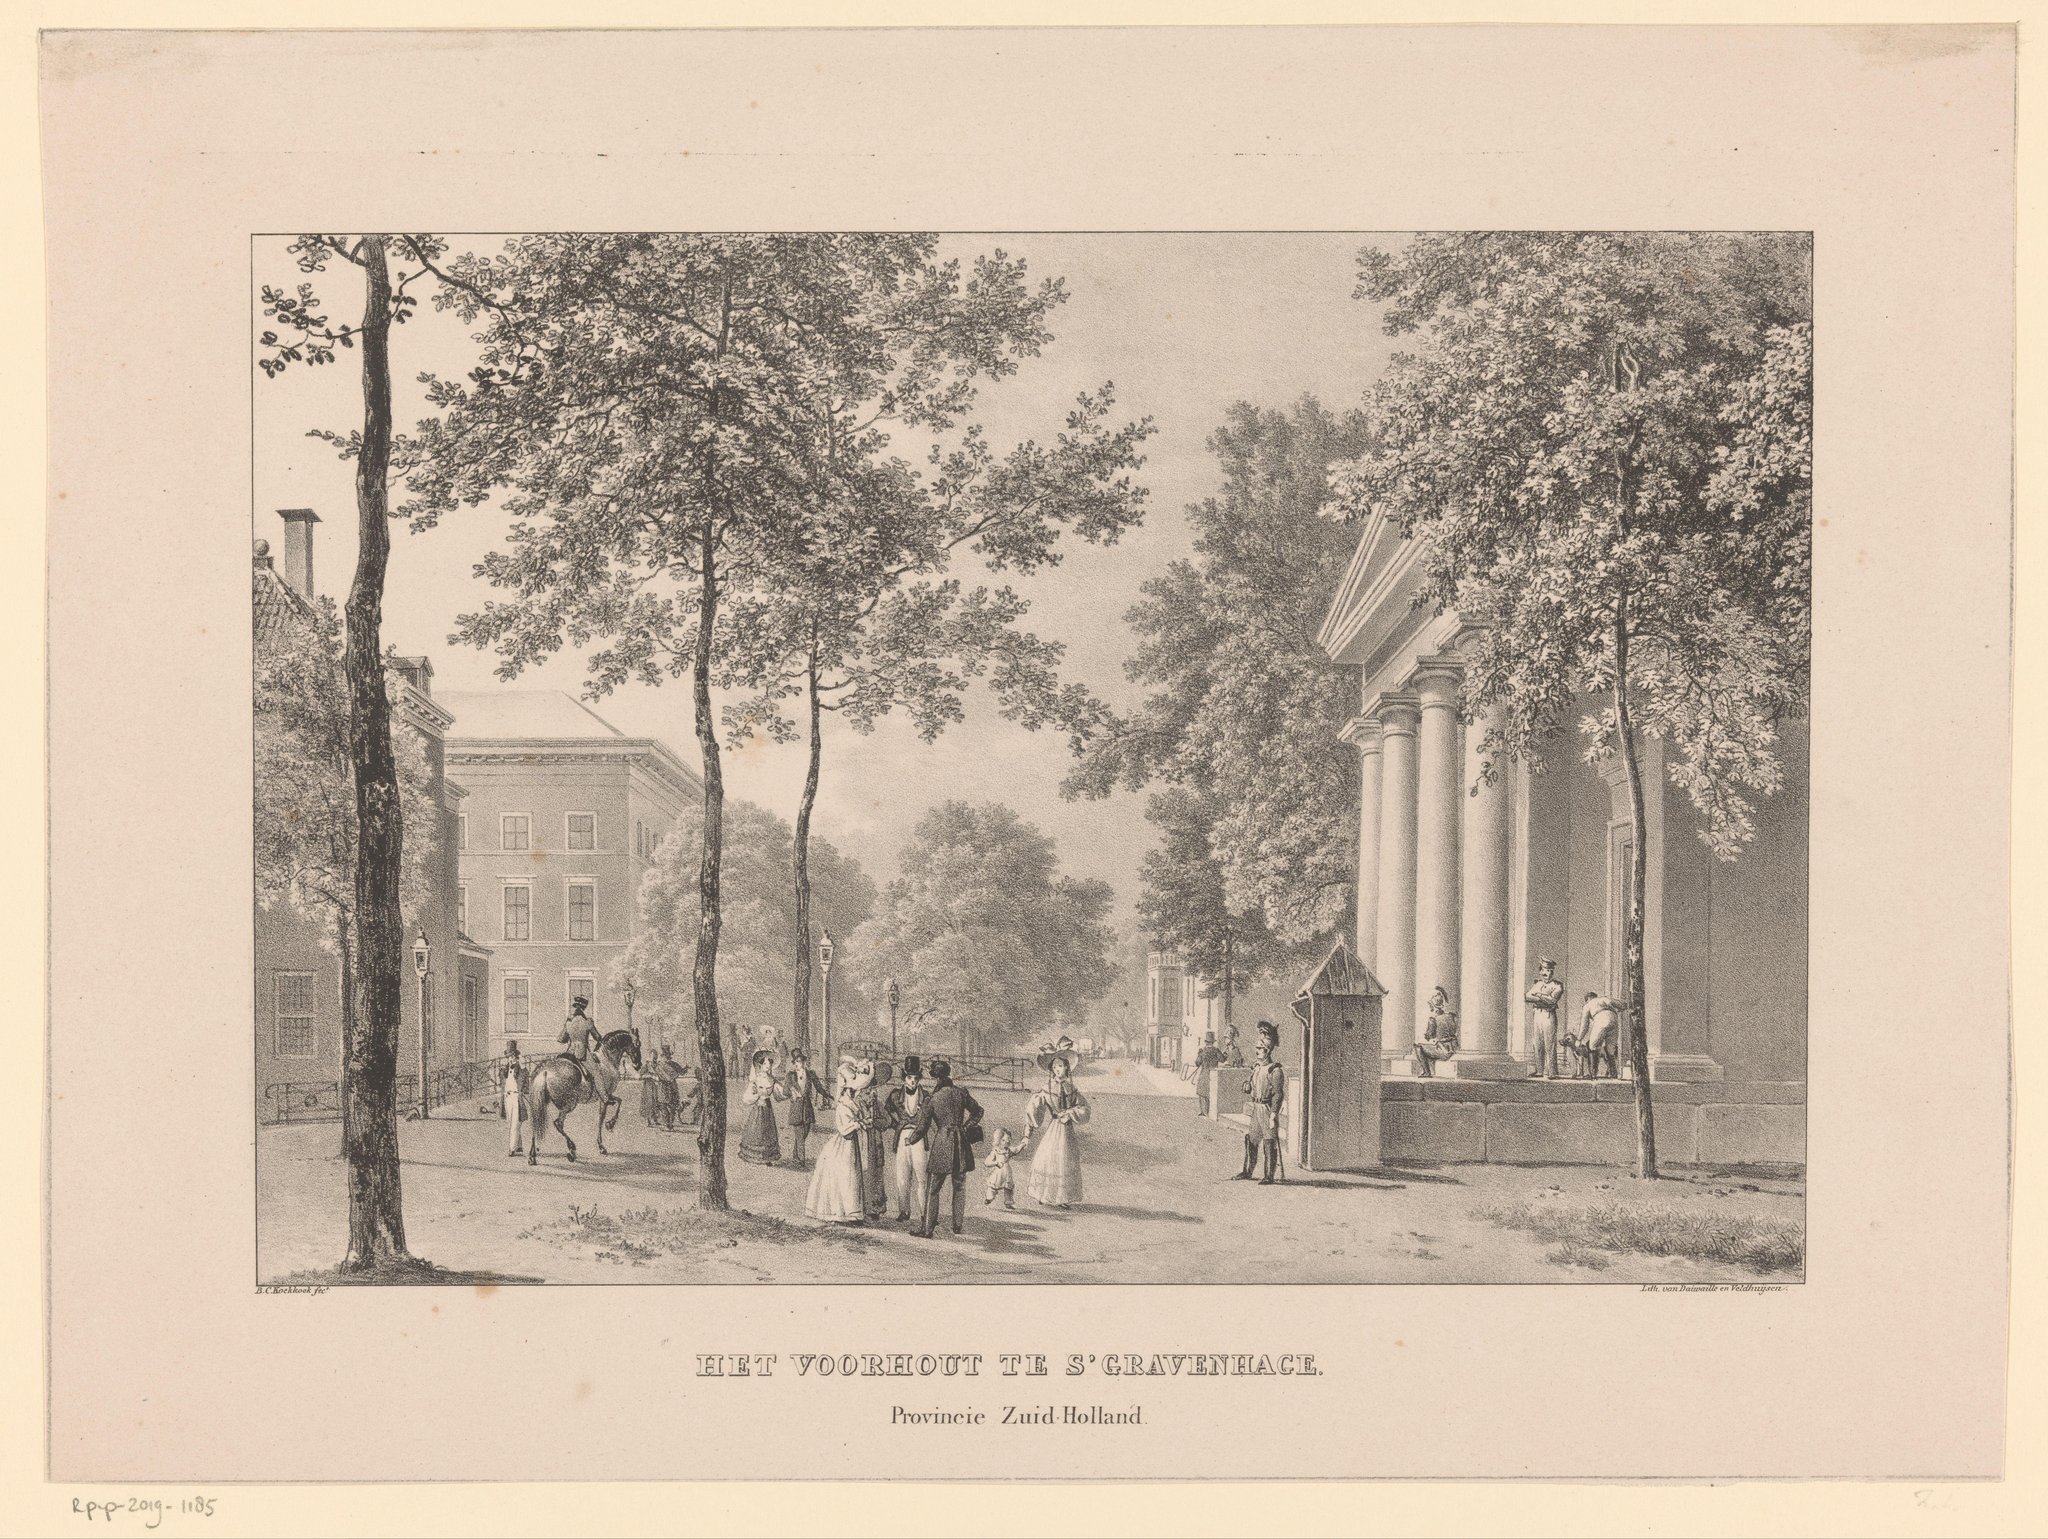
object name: print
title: Gezicht op het Korte Voorhout te Den Haag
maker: barend cornelis koekkoek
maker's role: draughtsman, painter, print maker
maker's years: 1803-1862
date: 1831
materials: paper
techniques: lithograph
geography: amsterdam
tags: street (+ city(-scape) with figures, staffage)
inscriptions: collector's mark: Lugt 2228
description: Gezicht op het Korte Voorhout, bij de Koningsbrug, of Boschburg, met rechts 'Het Wachtje', het wachthuis. In het midden staan en lopen figuren. Rechts een gebouw met zuilen en een timpaan. Ervoor staan soldaten op wacht.